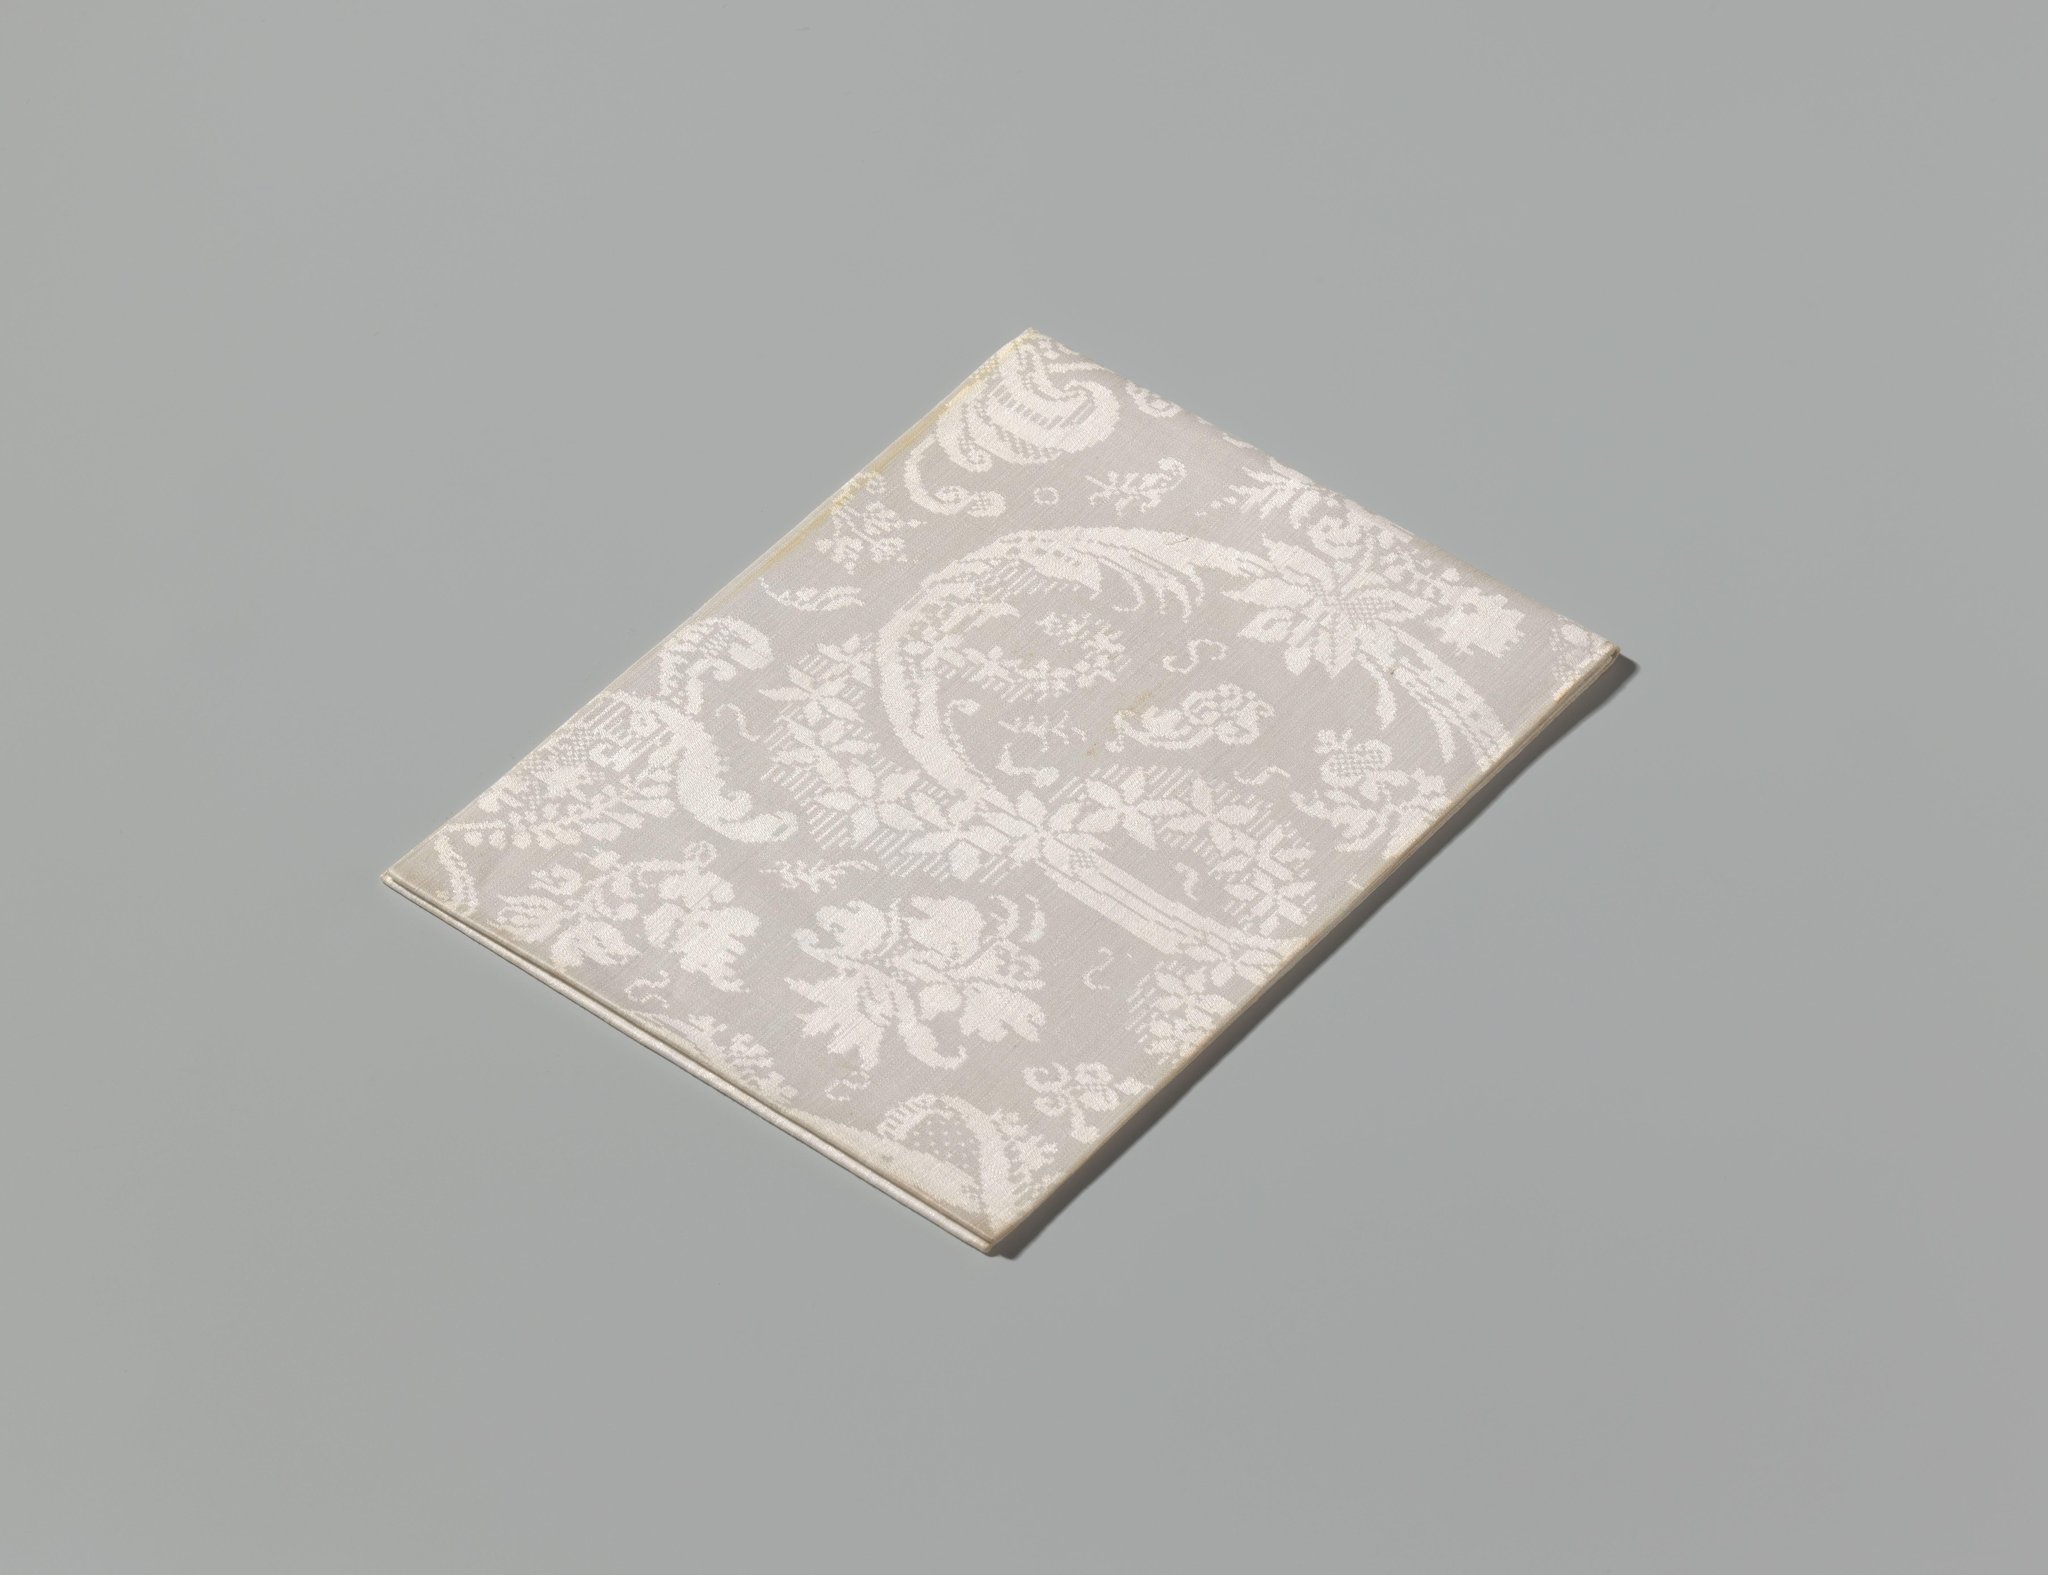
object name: napkin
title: Servet van wit linnendamast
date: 1692-1700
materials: linen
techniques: damask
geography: northern netherlands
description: Wit linnendamasten servet met patroon van voluten, merk IS 24.